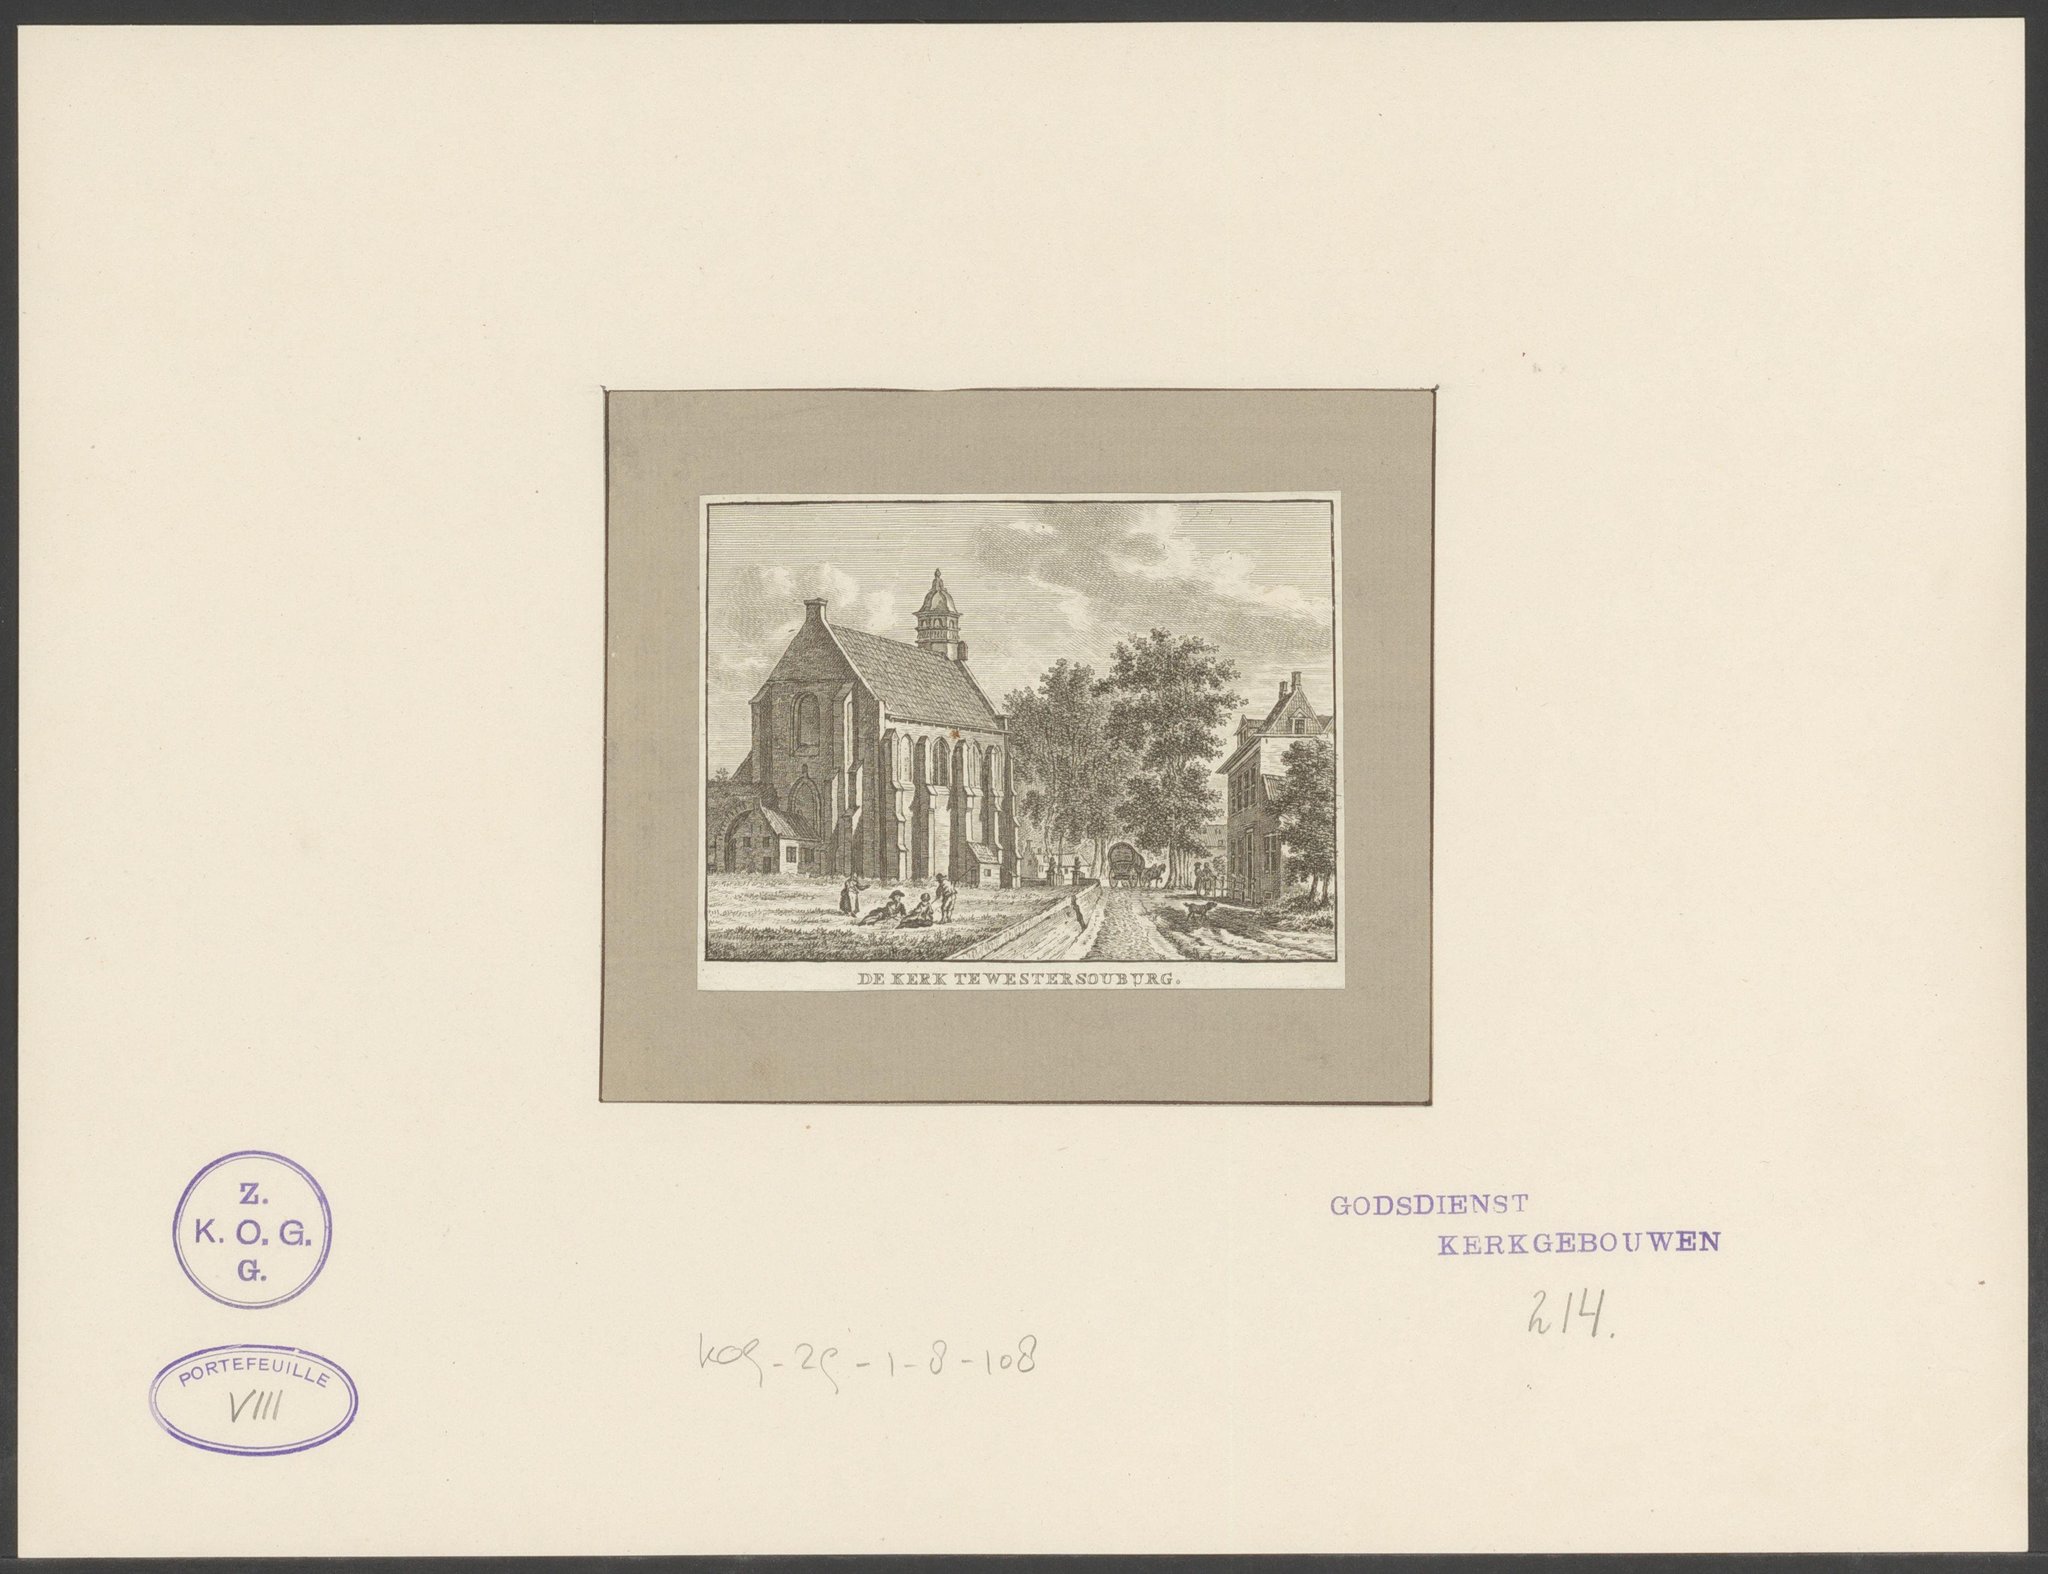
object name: print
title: Kerk te West-Souburg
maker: Anonymous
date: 1740-1795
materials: paper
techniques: engraving, etching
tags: village, church (exterior)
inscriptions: collector's mark, collector's mark: Lugt 1641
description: Gezicht op de kerk te West-Souburg. Onderwerpsrubrieken binnen de Atlas Zeden en Gewoonten: Kerk en kerkwezen & Armwezen en liefdadige instellingen; Kerkgebouwen elders. V-Z.